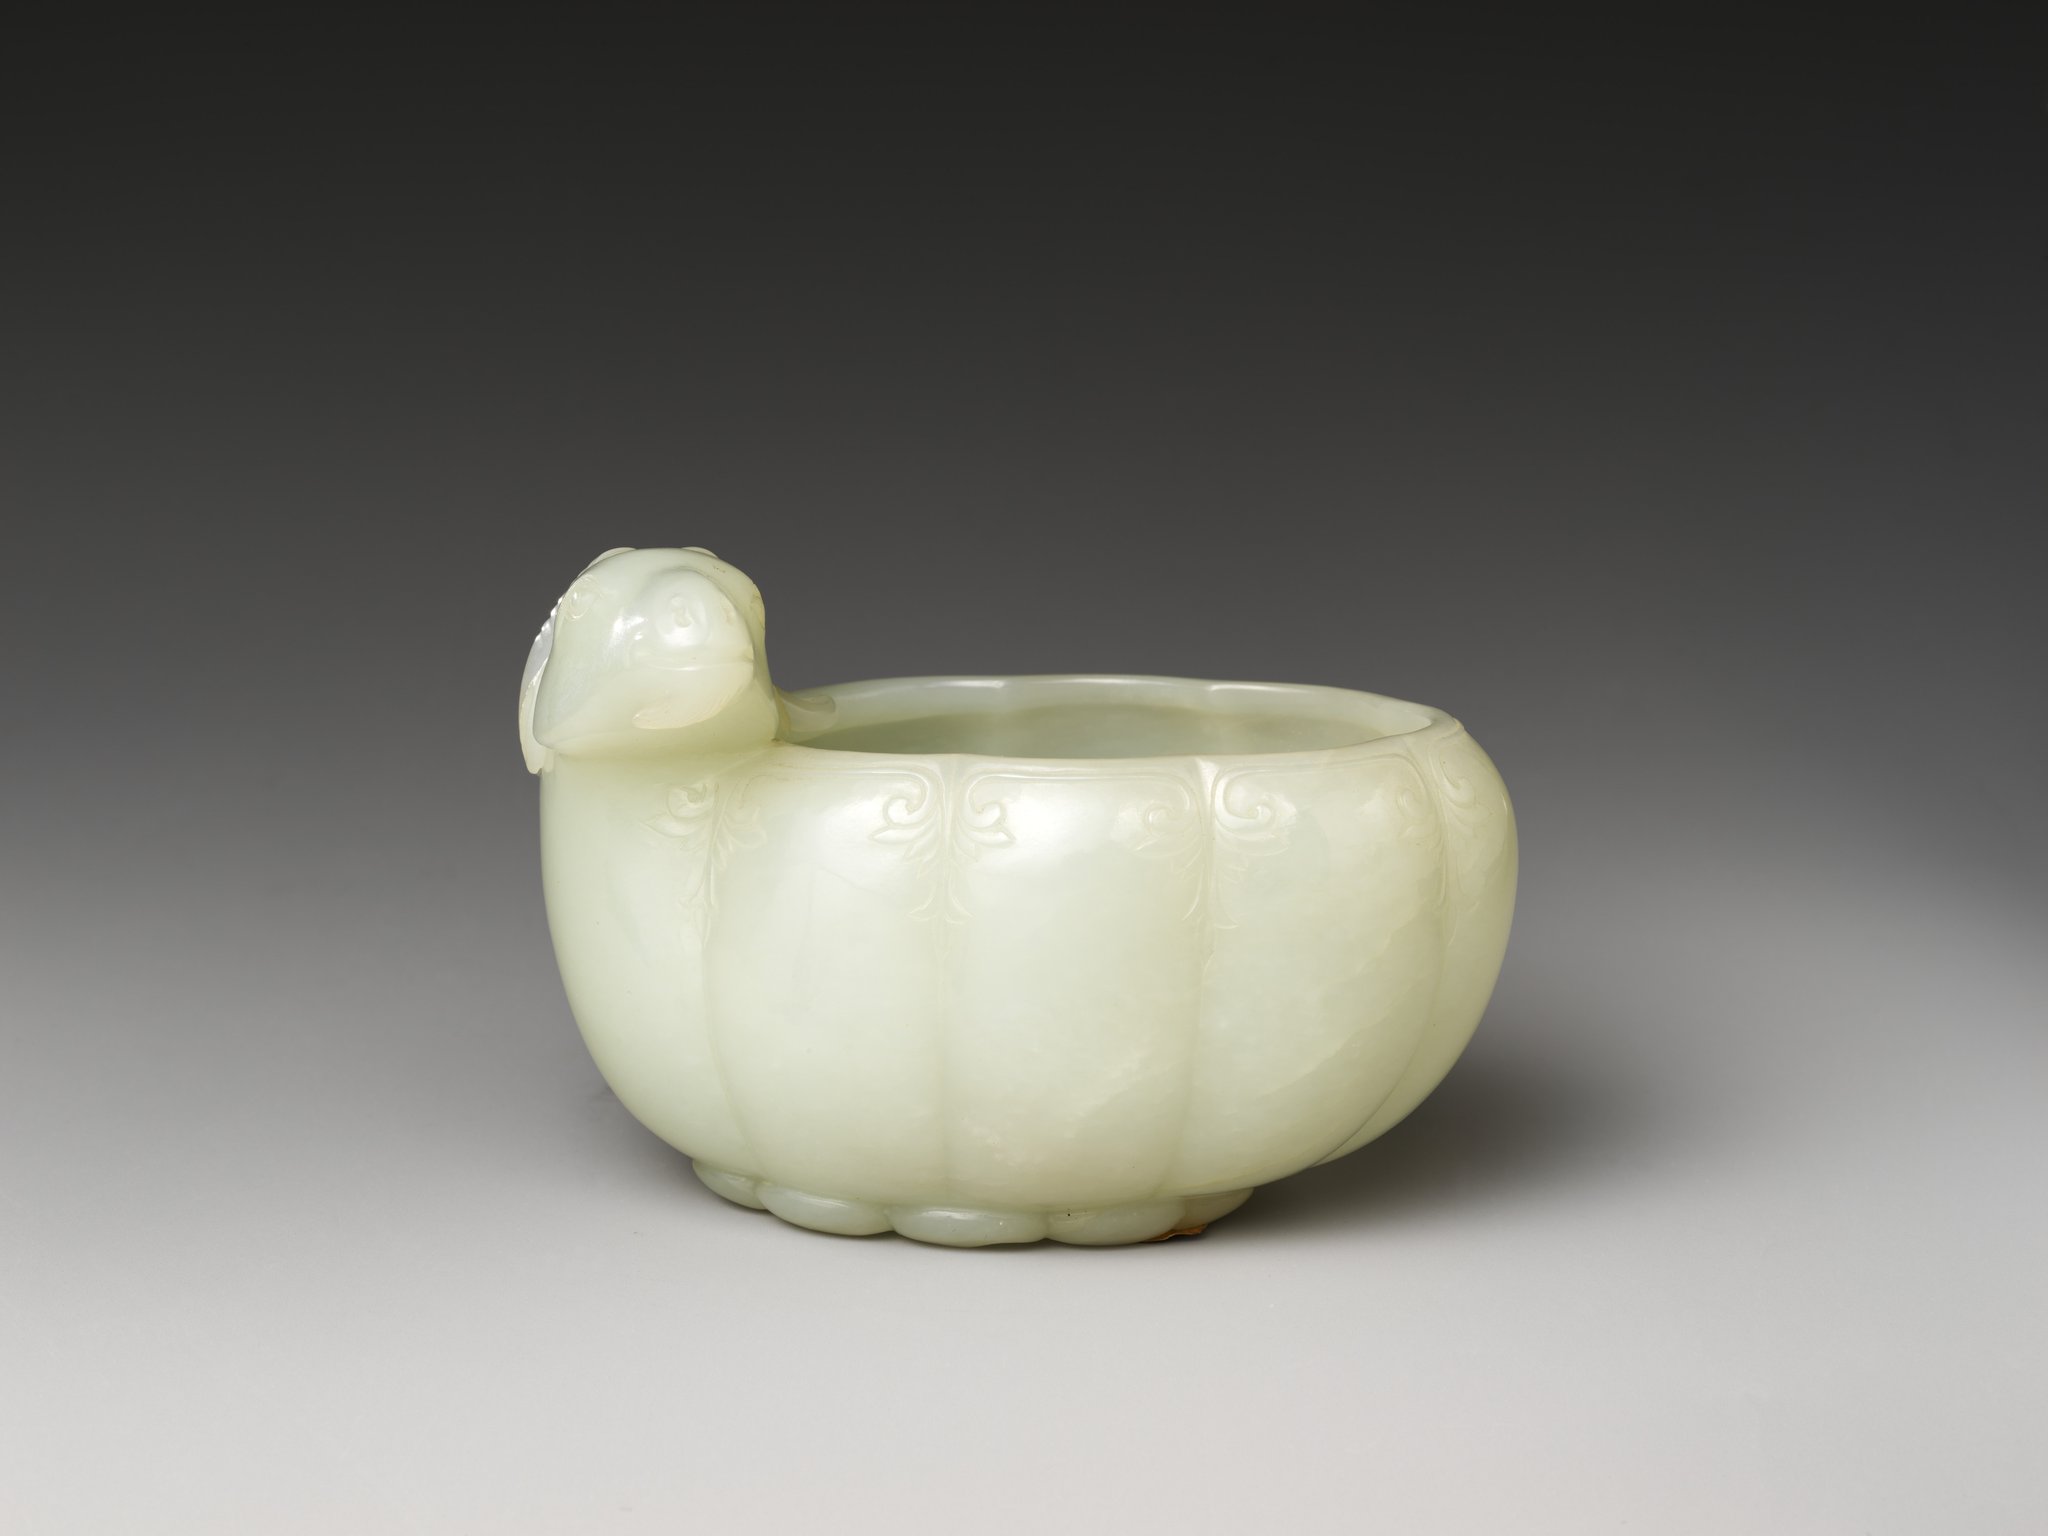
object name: bowl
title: Bowl in the shape of a ram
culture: chinese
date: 1751-1800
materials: jade